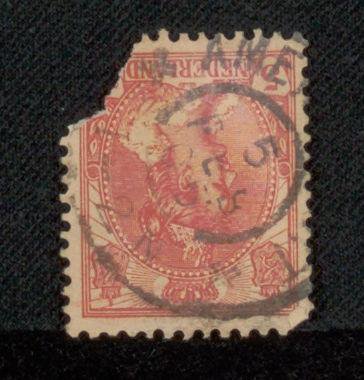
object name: envelope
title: Envelop aan Philip Zilcken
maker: wijnand otto jan nieuwenkamp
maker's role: draughtsman, print maker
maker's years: 1874-1950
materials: ink, paper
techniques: pen, printing, writing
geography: amersfoort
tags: the hague, painter, philip zilcken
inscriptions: collector's mark: ‘RPK’, name: ‘RPK’